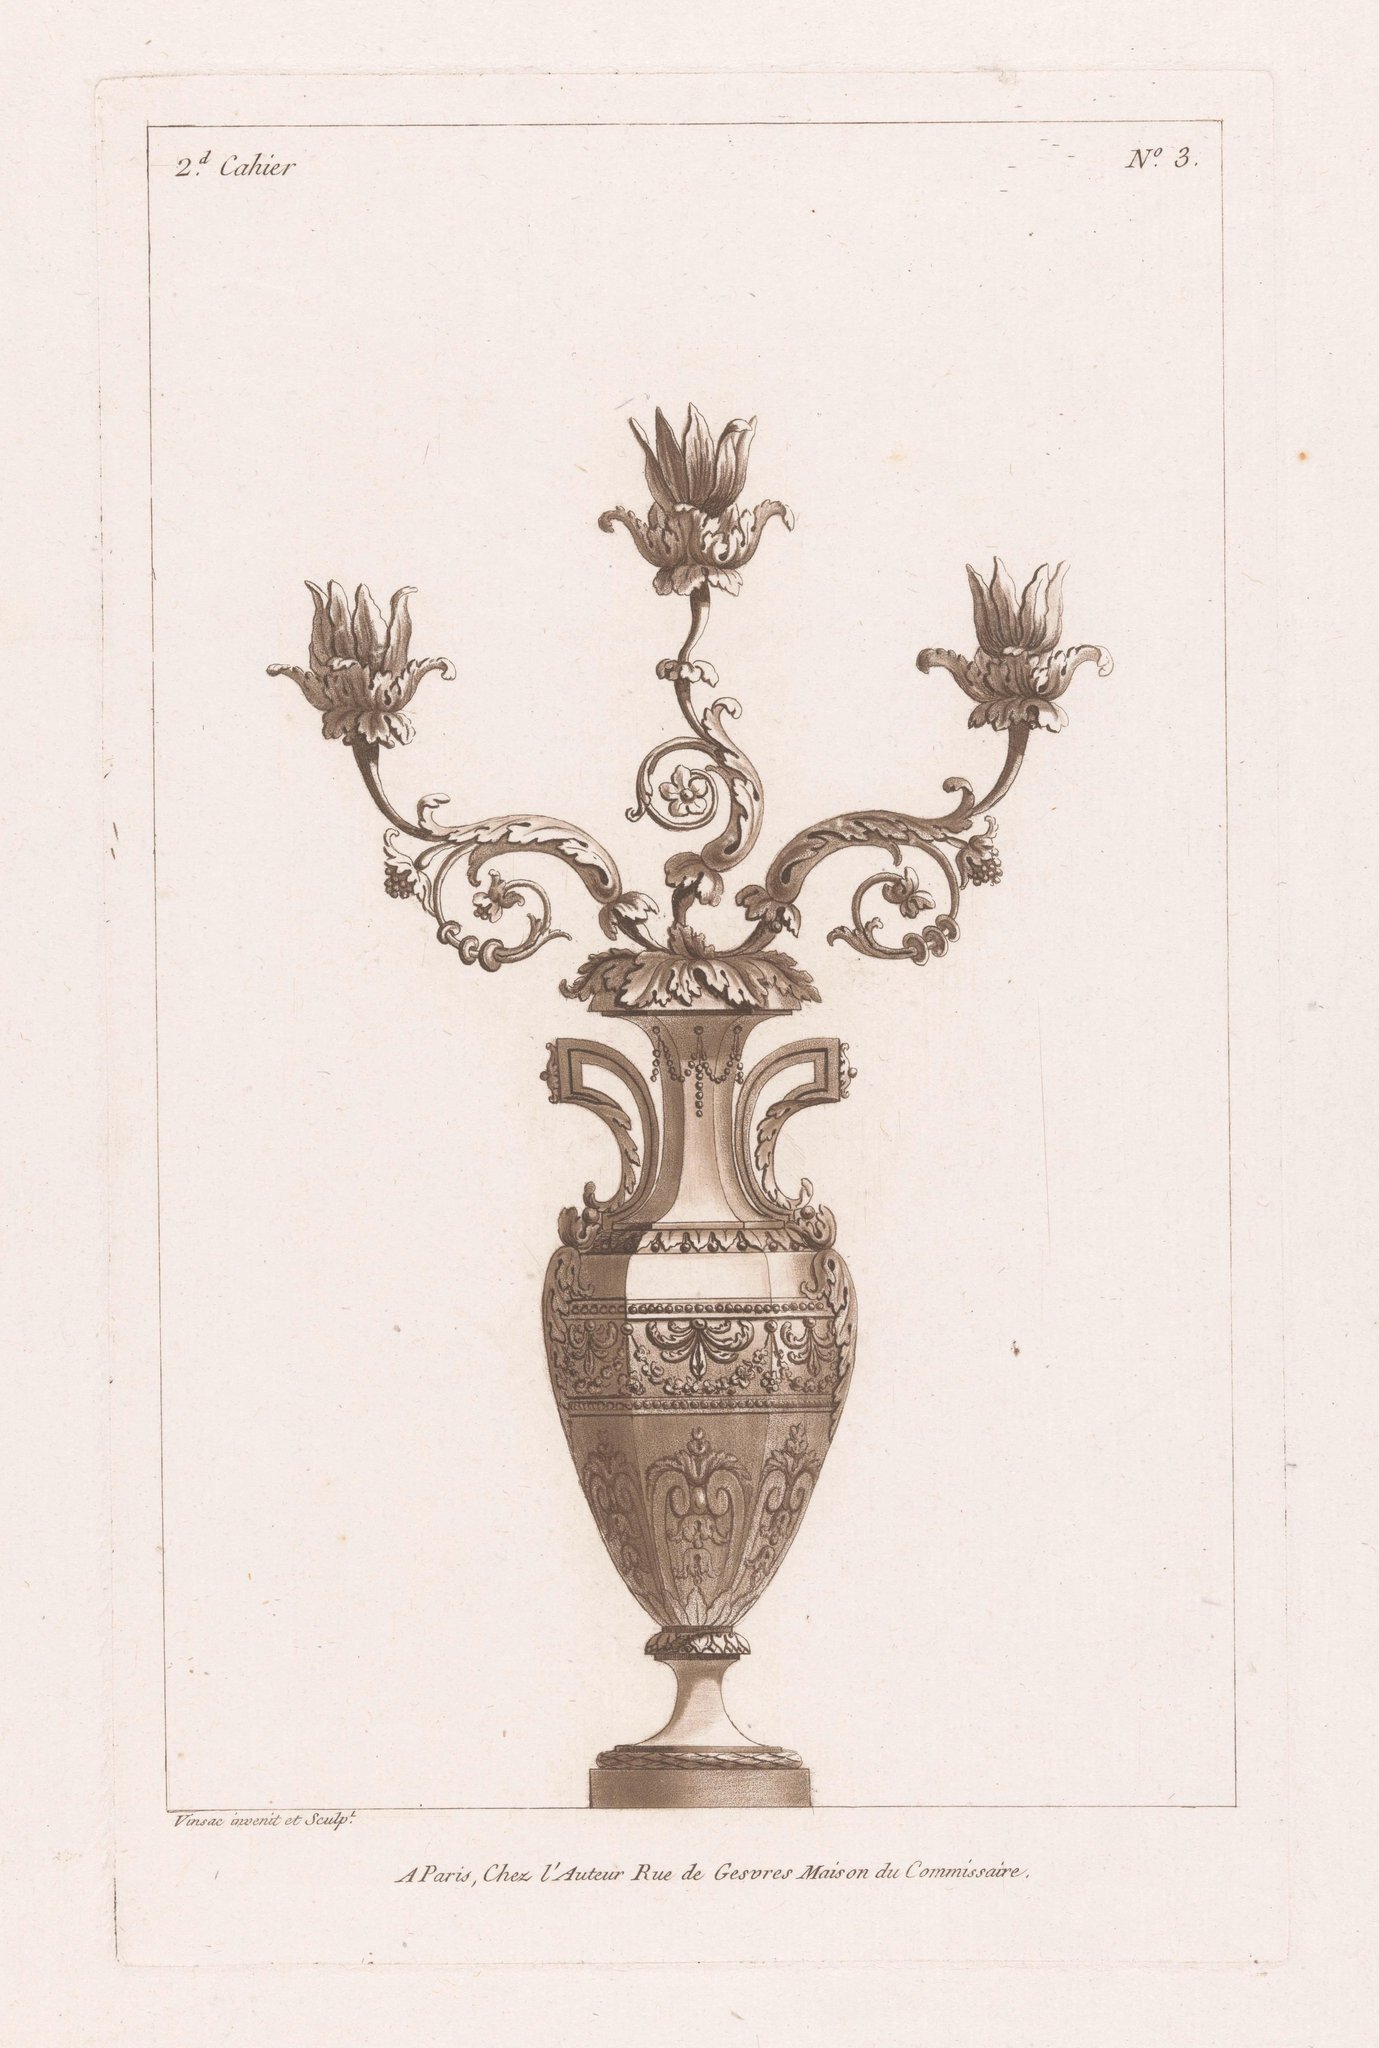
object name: ornament print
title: 2d Cahier / Cahier de Vases qui servent de Girandole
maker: claude dominique vinsac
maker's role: print maker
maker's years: 1749-1800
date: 1759-1800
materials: paper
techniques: aquatint, etching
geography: paris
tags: chandelier, candelabrum, flowers ~ ornament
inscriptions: collector's mark: Lugt 2228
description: Een driearmige girandole met bloemen en ranken op een geornamenteerde vaas.